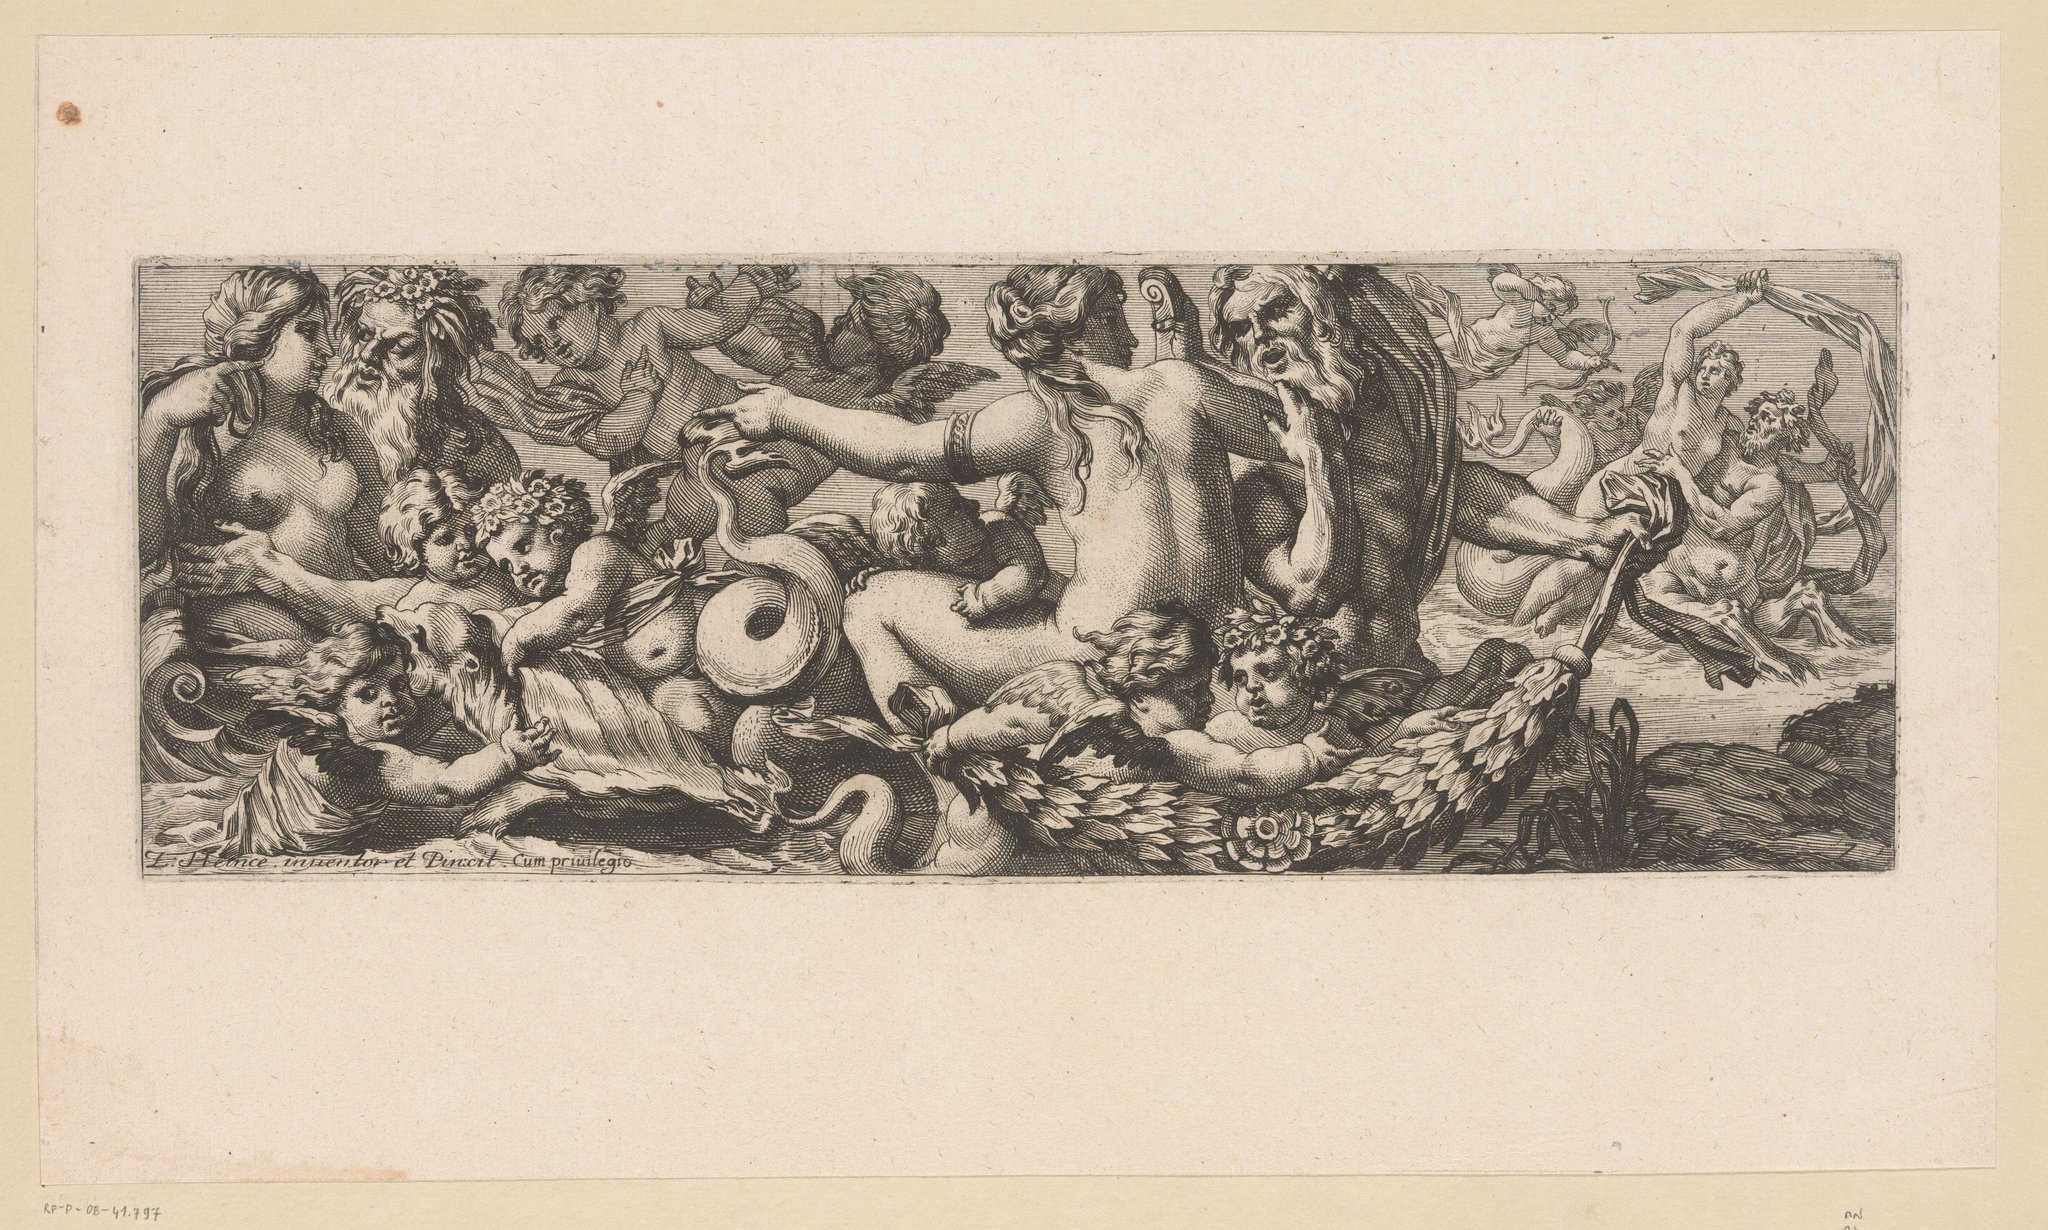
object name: print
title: Triomf van met Galatea met nereïden, saters en putti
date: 1630-1720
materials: paper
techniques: engraving, etching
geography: france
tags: nereids, daughters of nereus; sea-nymphs, triumph of galatea, satyr(s) (in general), cupids: 'amores', 'amoretti', 'putti'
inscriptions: collector's mark: Lugt 240